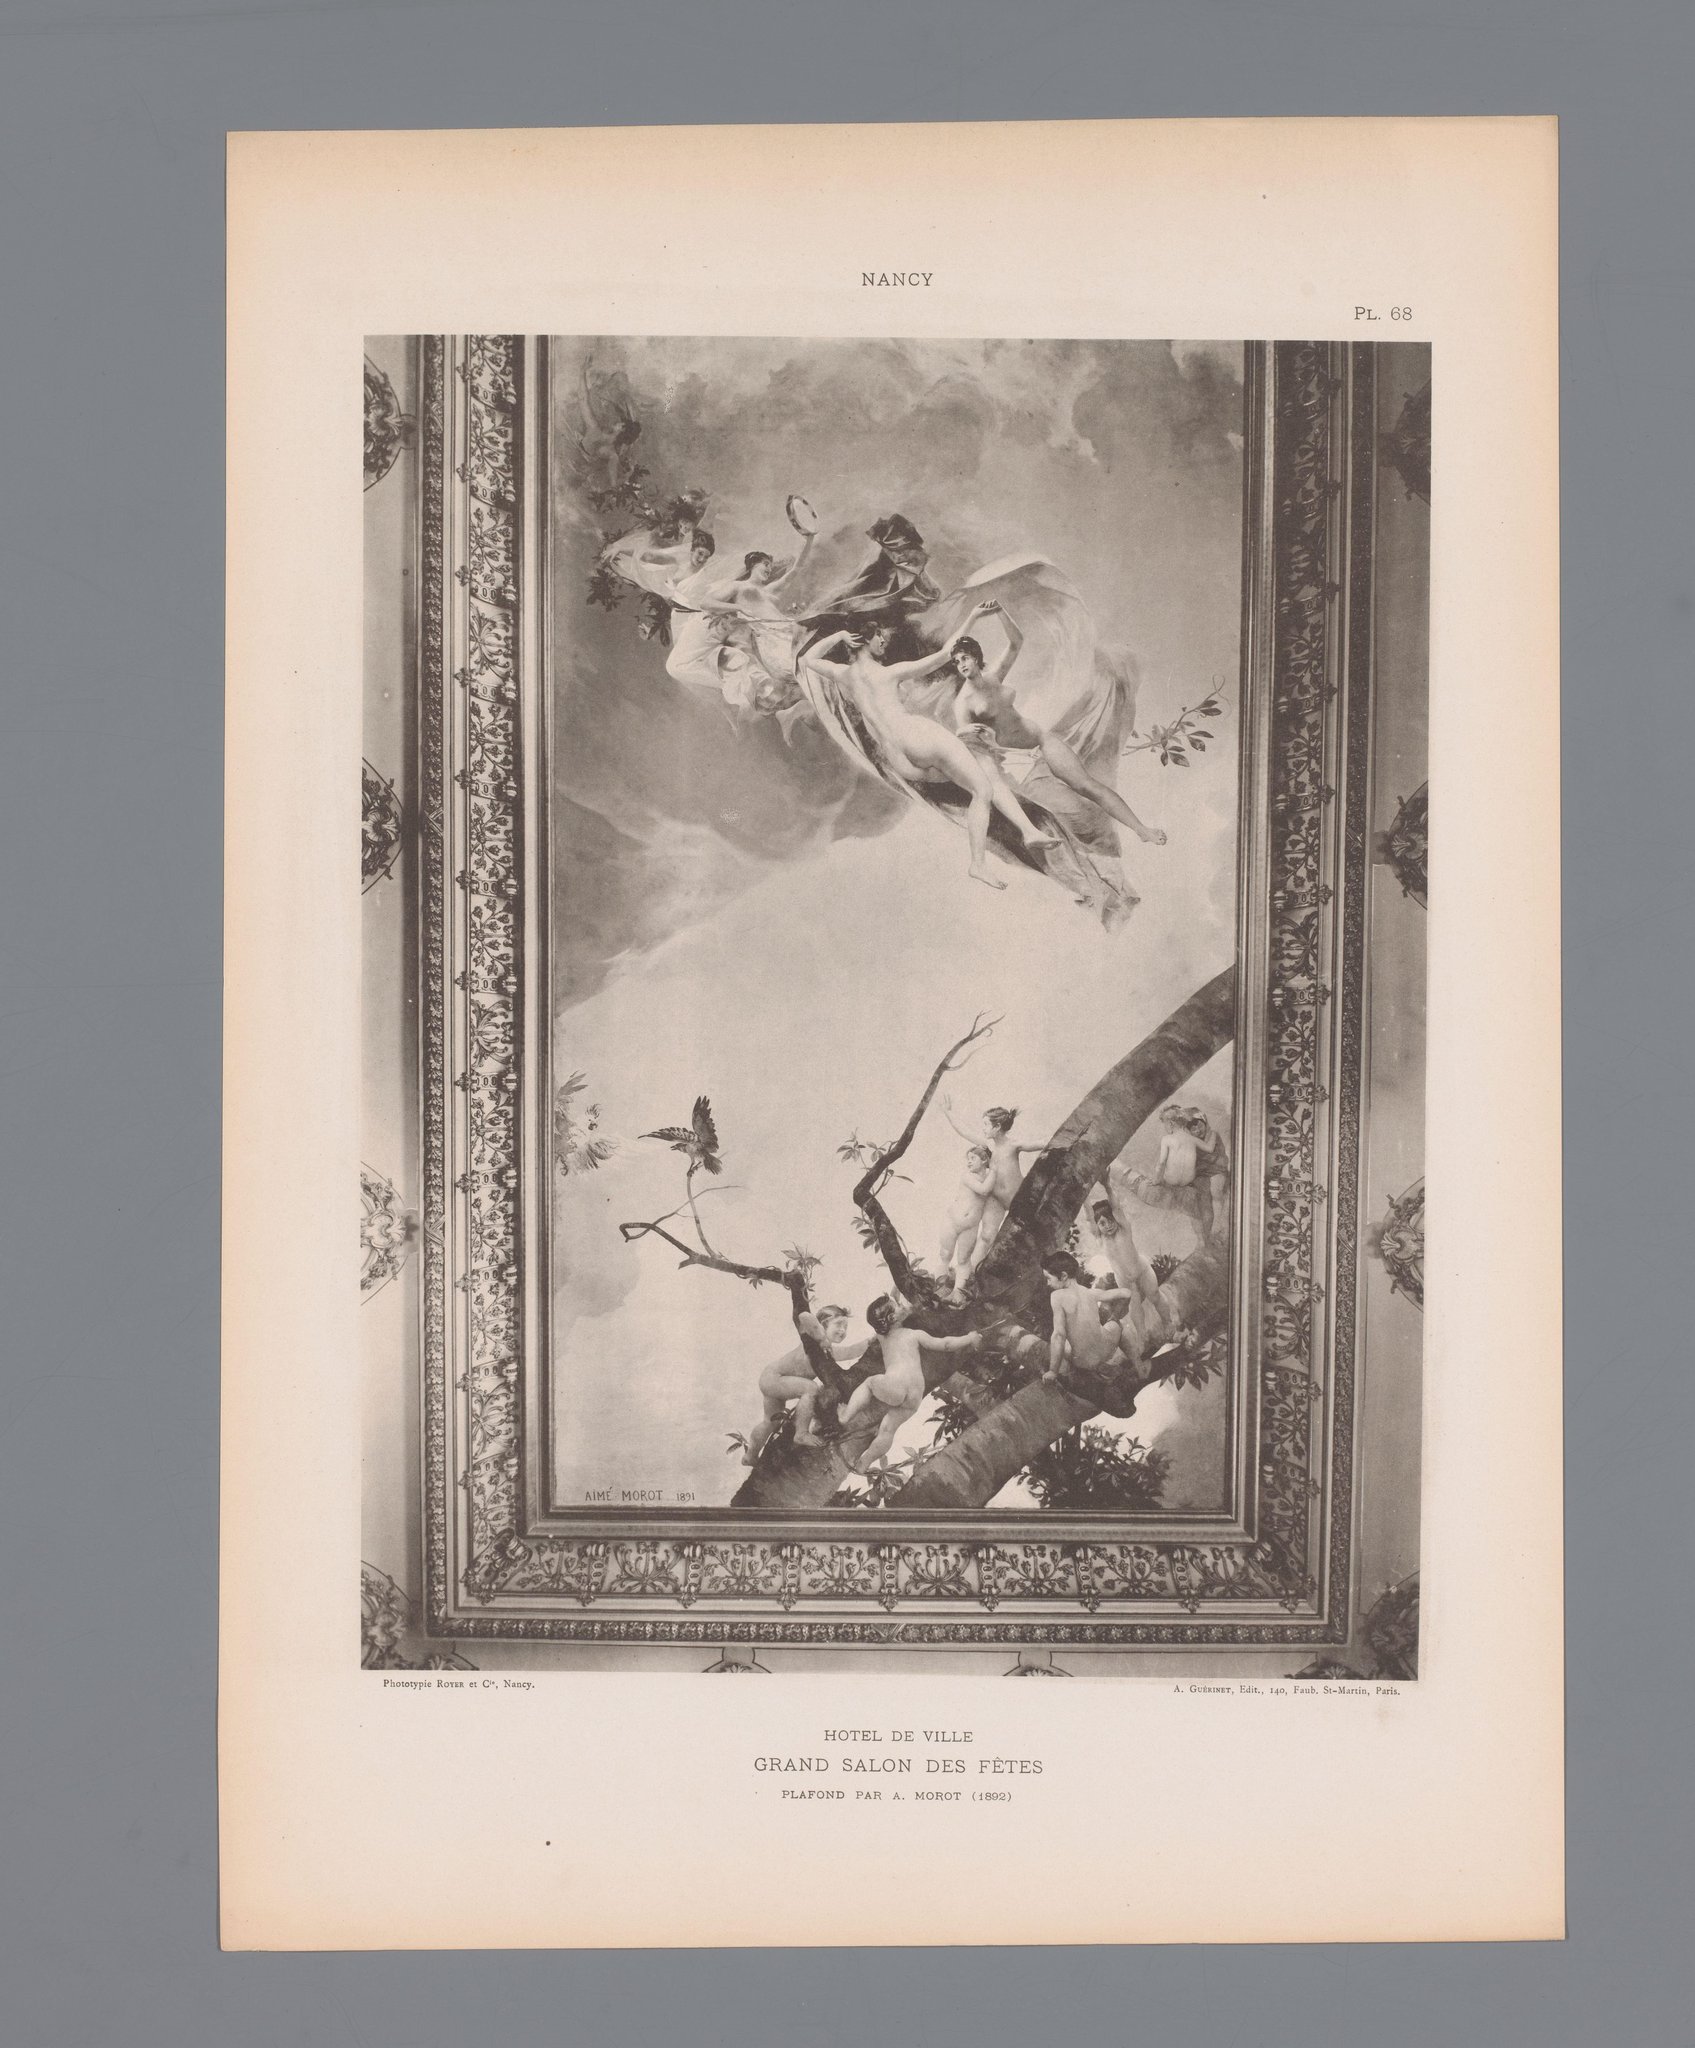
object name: photomechanical print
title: Plafond van de feestzaal in het stadhuis te Nancy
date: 1891-1896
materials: paper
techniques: photograph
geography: paris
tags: townhall, (decorated) ceiling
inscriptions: inscription: ‘Hotel de ville/ Grand salon des fêtes/ plafond par A. Morot (1892)’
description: Deze prent maakt deel uit van een omslag met 103 prenten op 101 bladen en een titelblad.